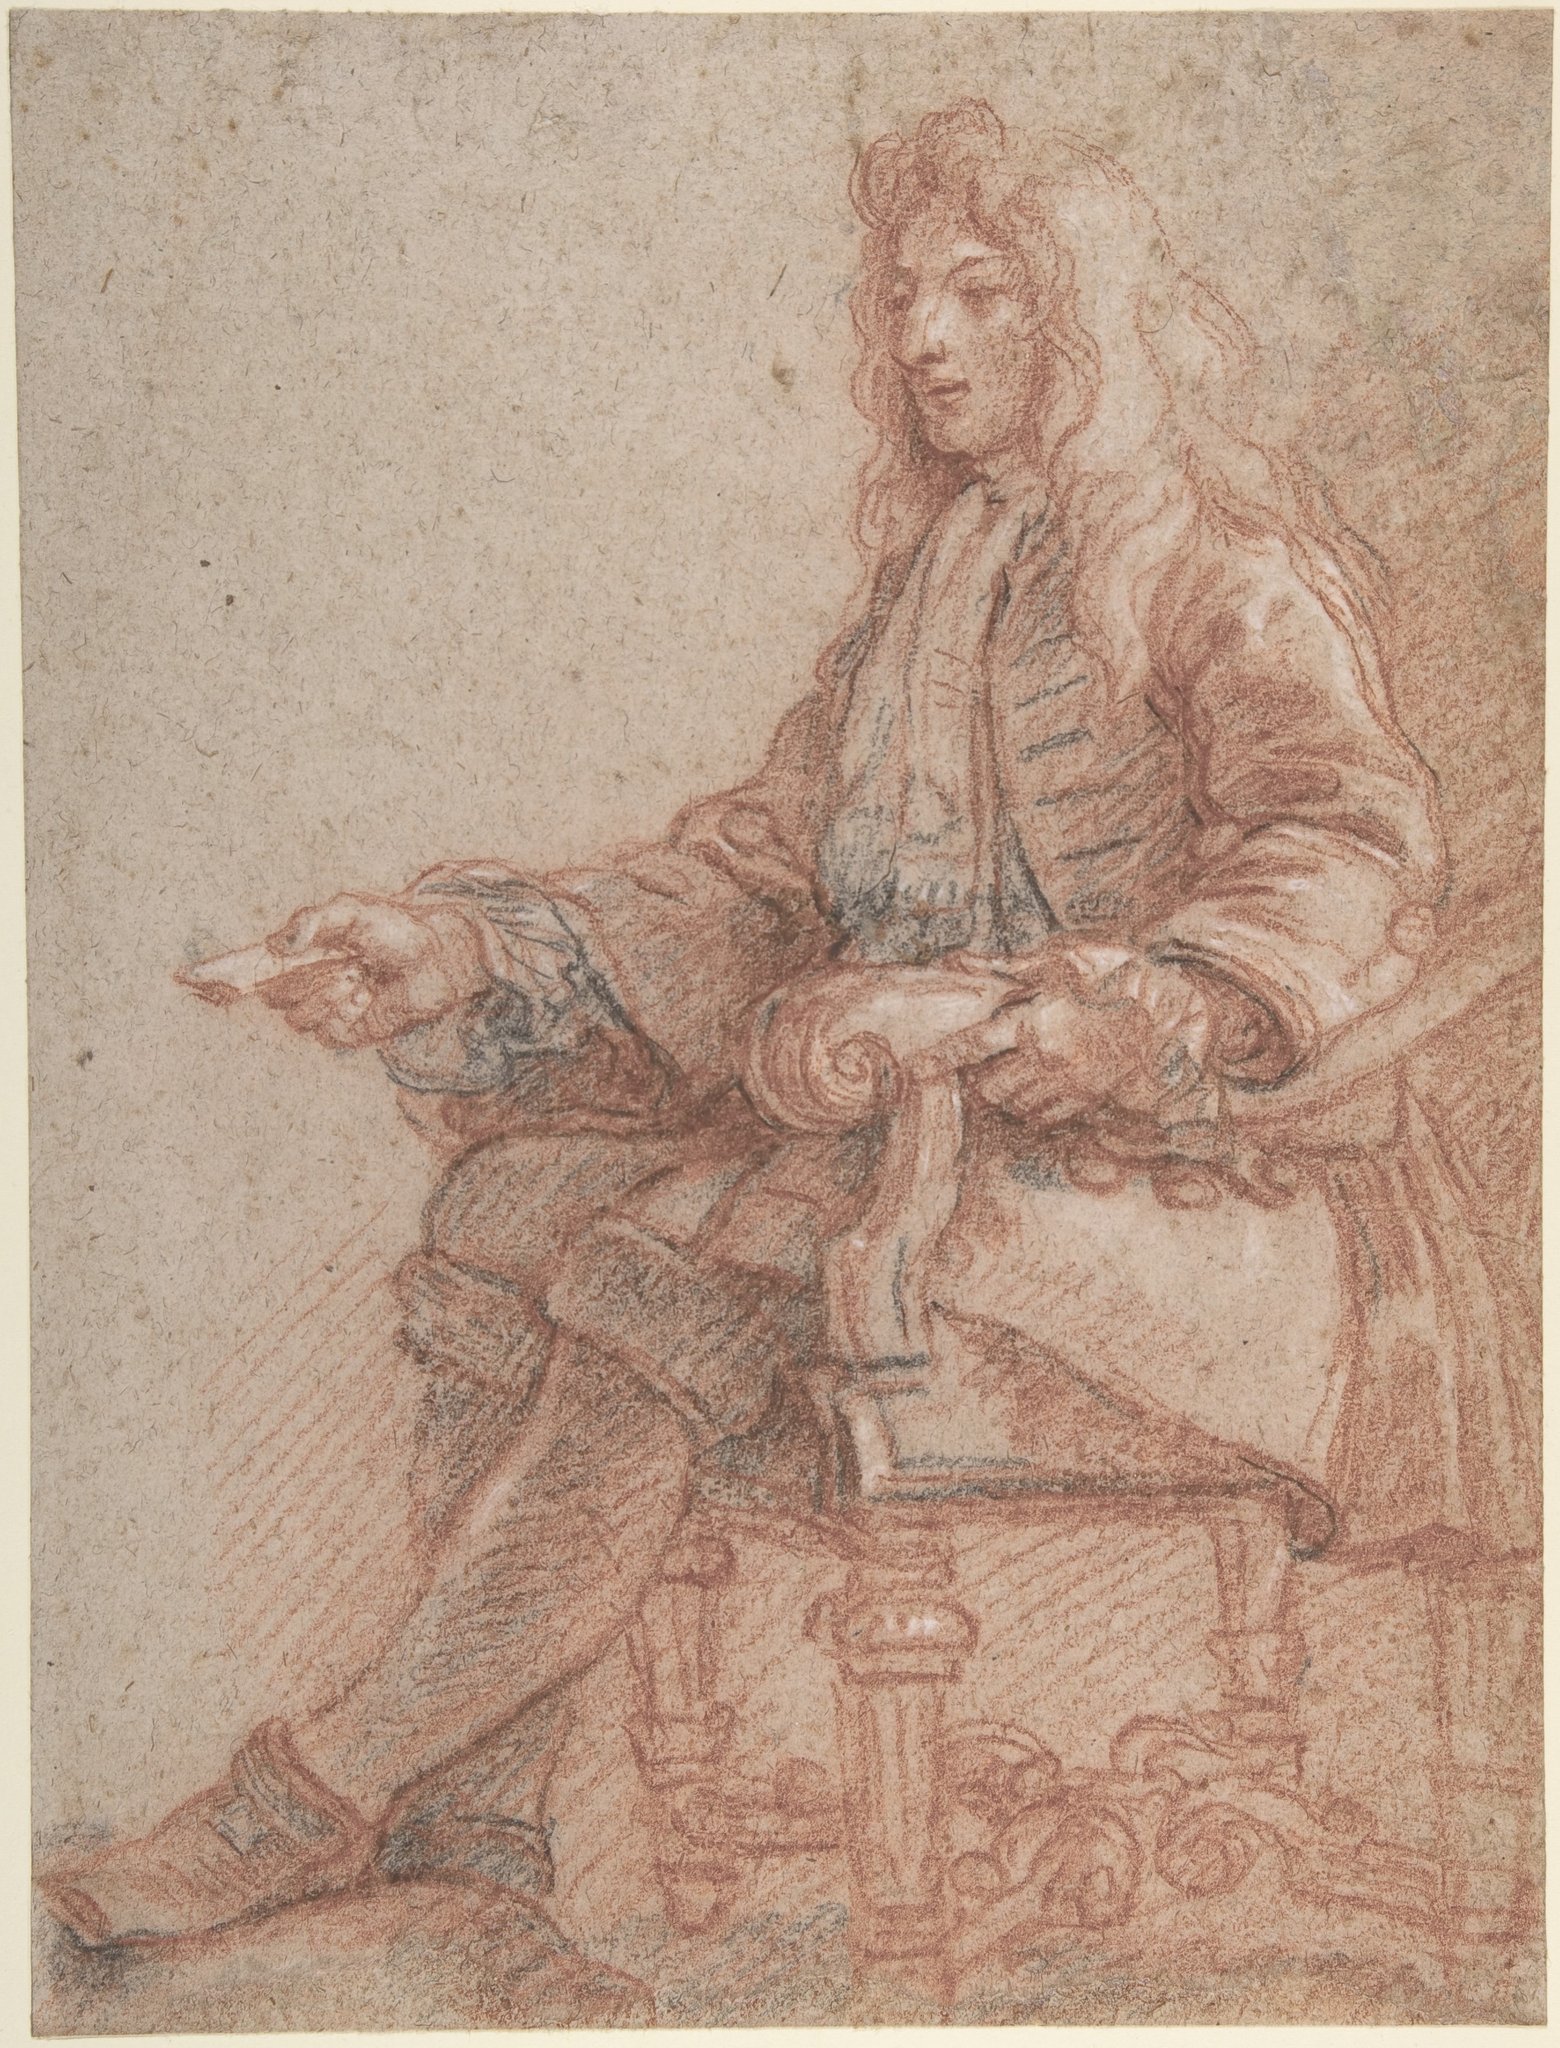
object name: drawing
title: Gentleman Seated in an Armchair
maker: charles de la fosse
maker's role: artist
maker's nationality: french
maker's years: 1636-1716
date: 1667-1733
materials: chalk, paper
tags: men,chairs